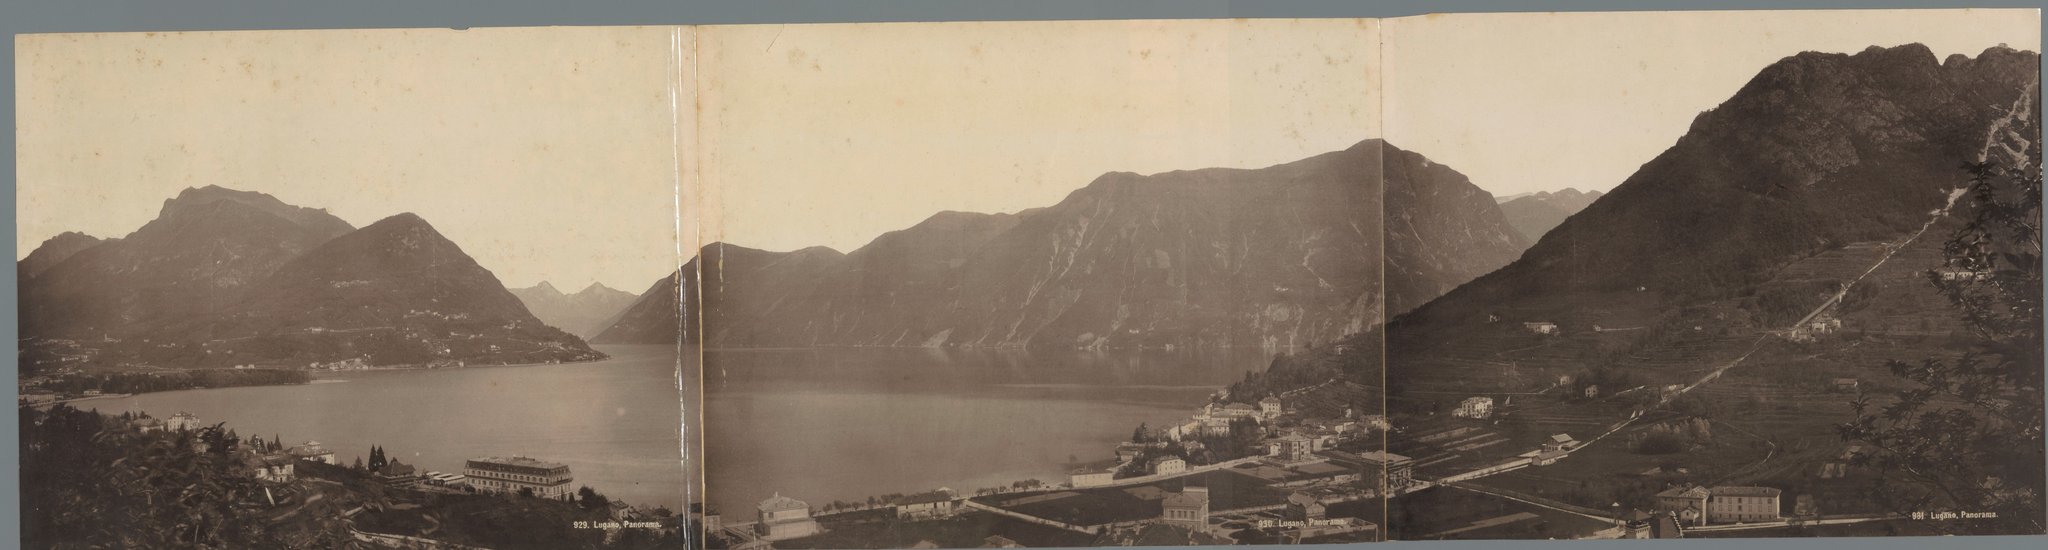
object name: panorama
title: Lugano, Panorama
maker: Anonymous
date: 1870-1895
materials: paper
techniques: photograph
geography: zurich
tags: lake, prospect of city, town panorama, silhouette of city, mountains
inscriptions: number: ‘929./ 930./ 931.’, collector's mark: ‘VOSMAER’